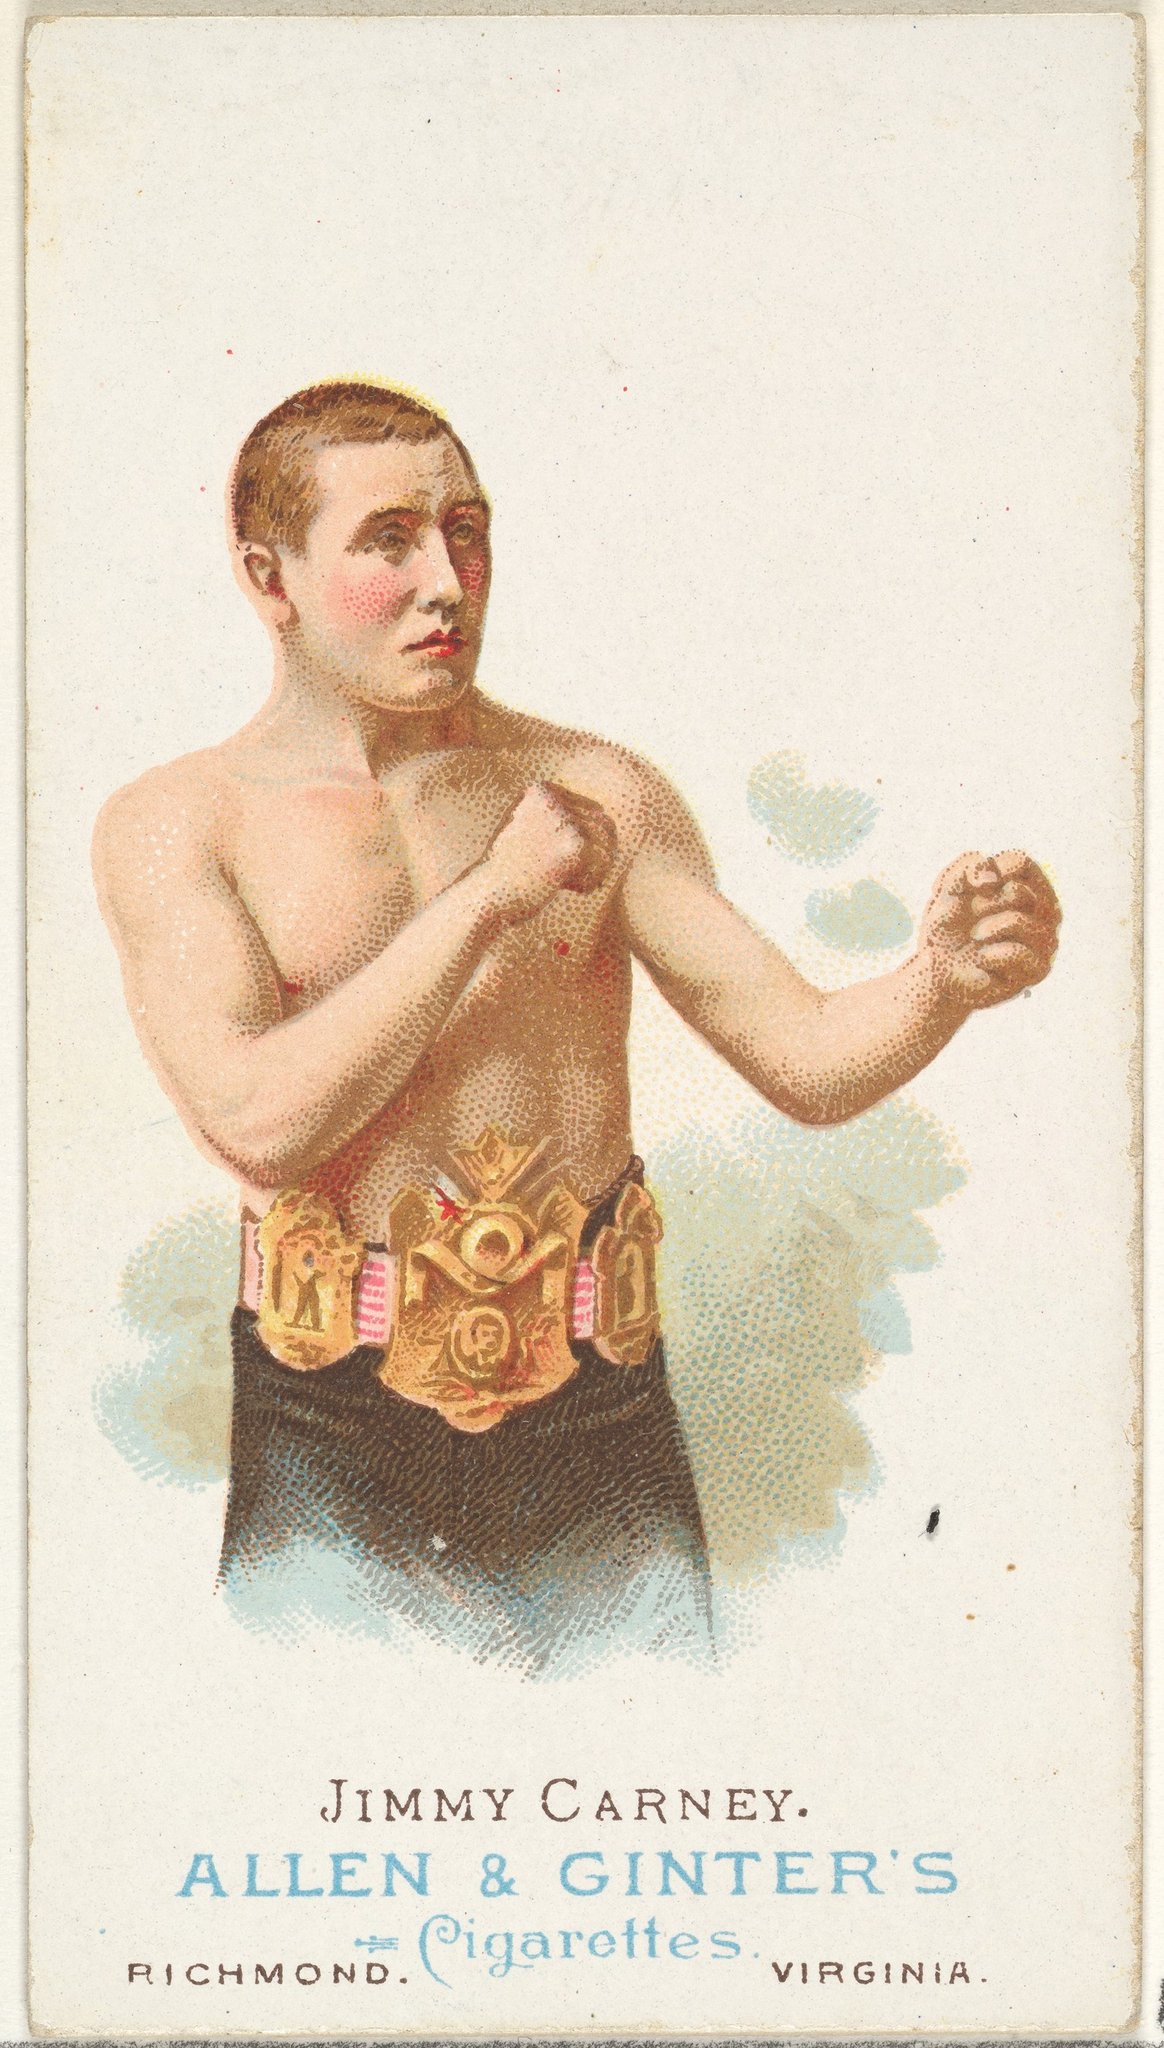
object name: print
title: Jimmy Carney, Pugilist, from World's Champions, Series 1 (N28) for Allen & Ginter Cigarettes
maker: allen & ginter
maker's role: publisher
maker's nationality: american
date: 1887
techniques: color lithograph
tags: men,portraits,boxing,athletes